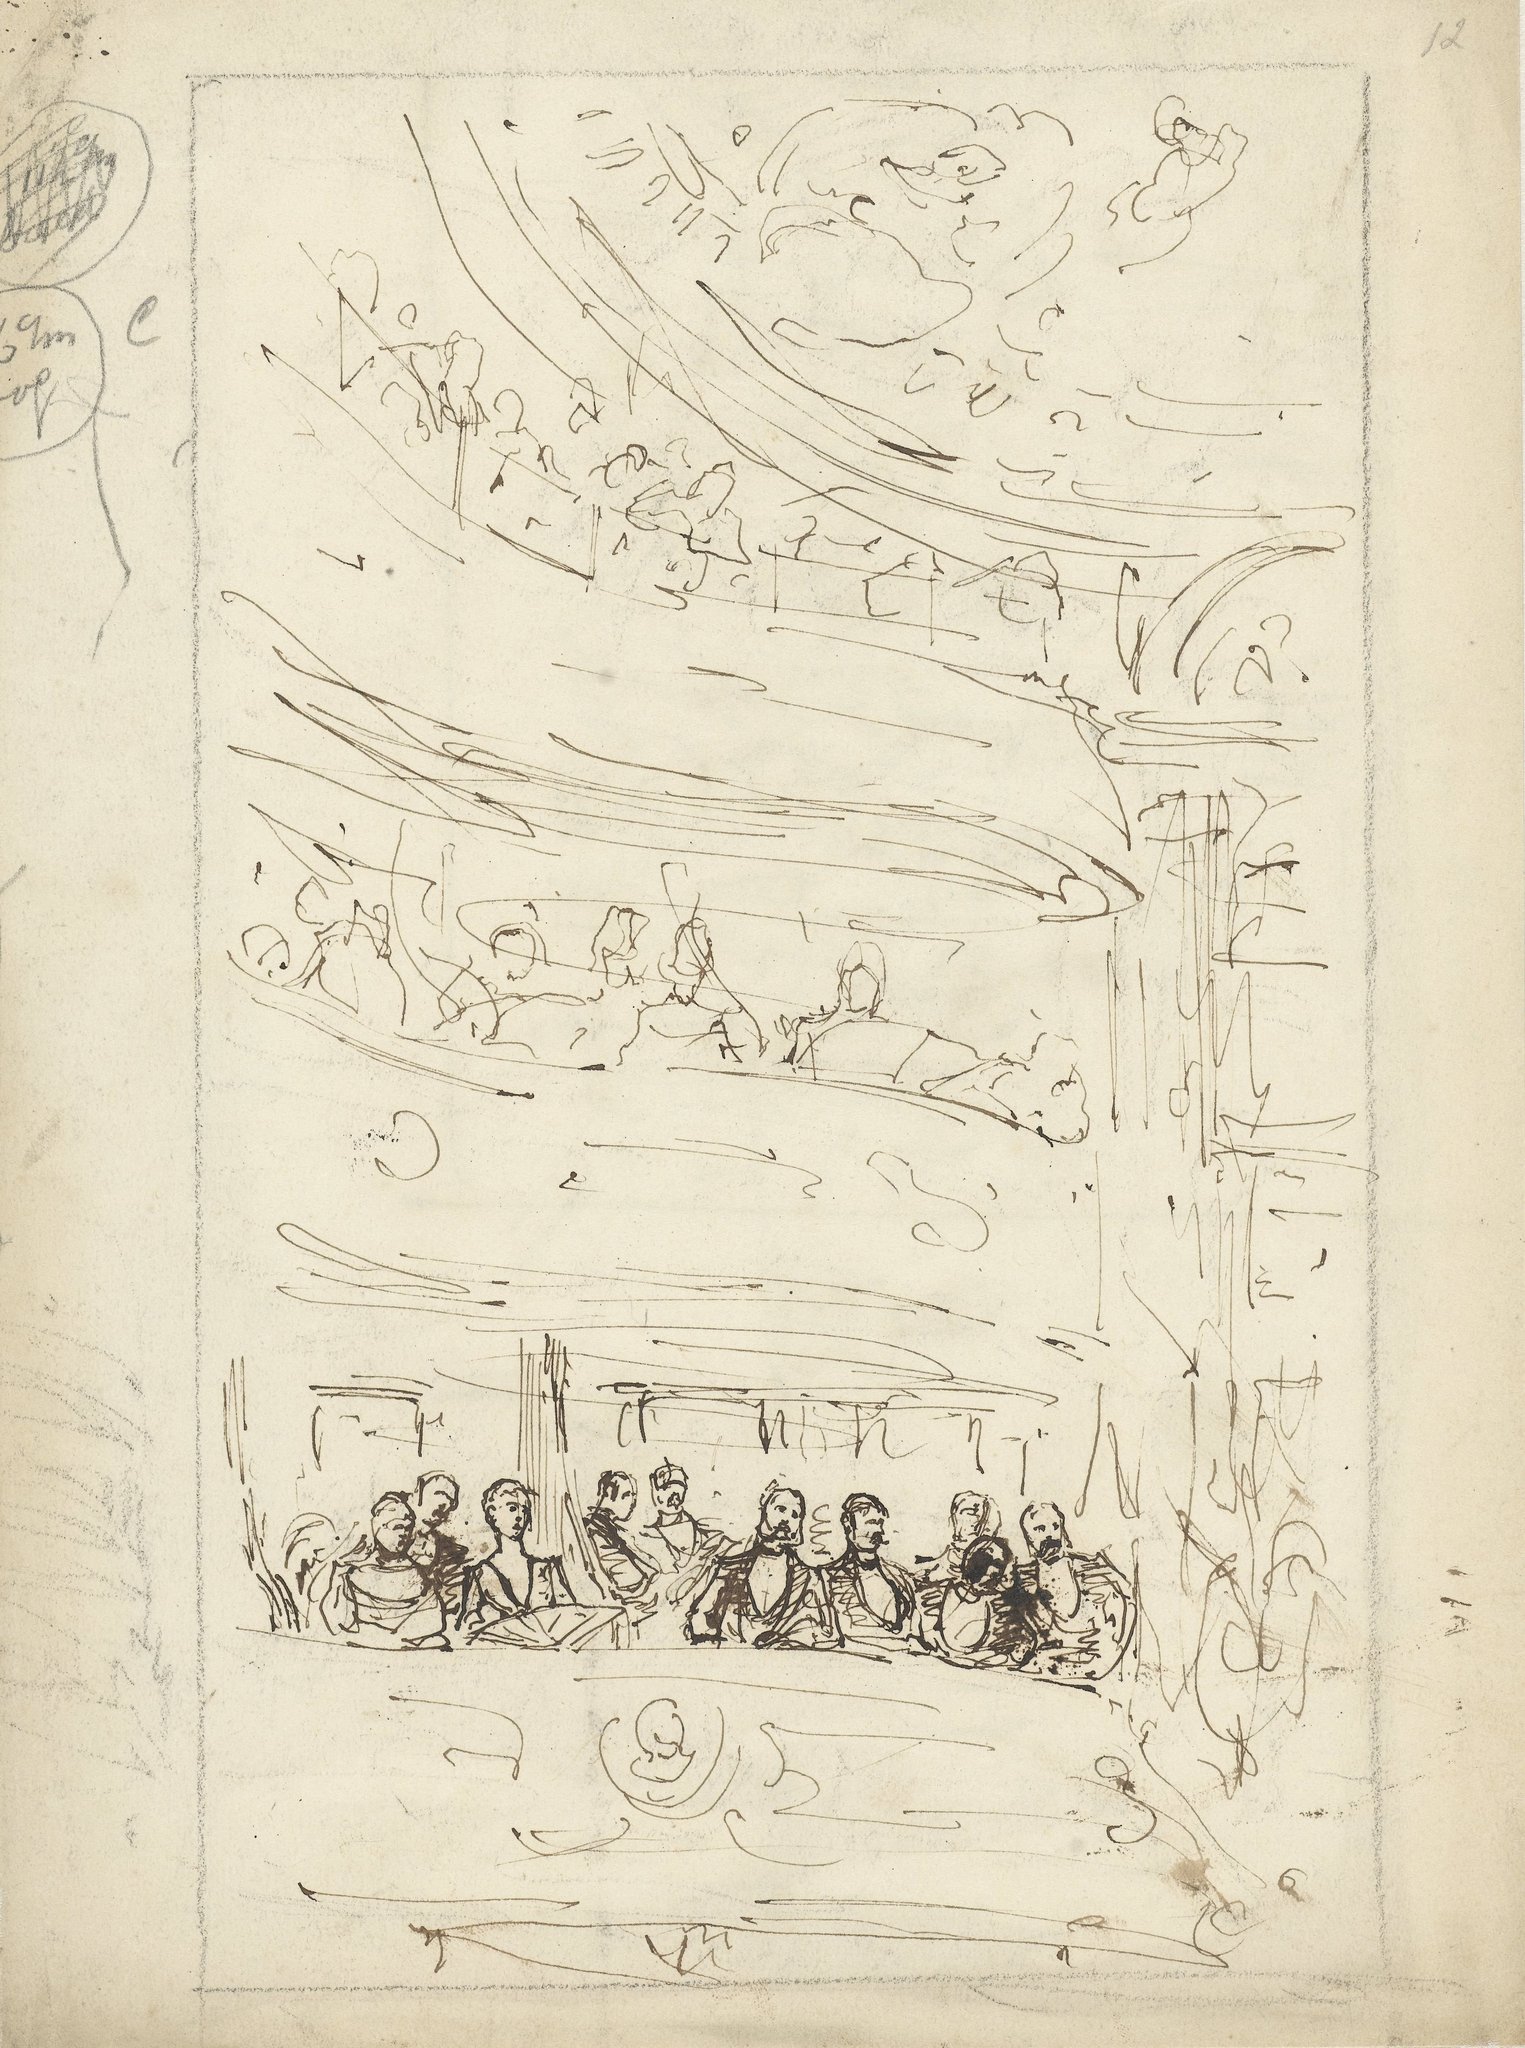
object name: drawing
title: Koninklijke loge in de schouwburg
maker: marius bauer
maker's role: draughtsman, print maker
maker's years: 1867-1932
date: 1877-1932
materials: ink, paper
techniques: pen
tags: the audience ~ art performance